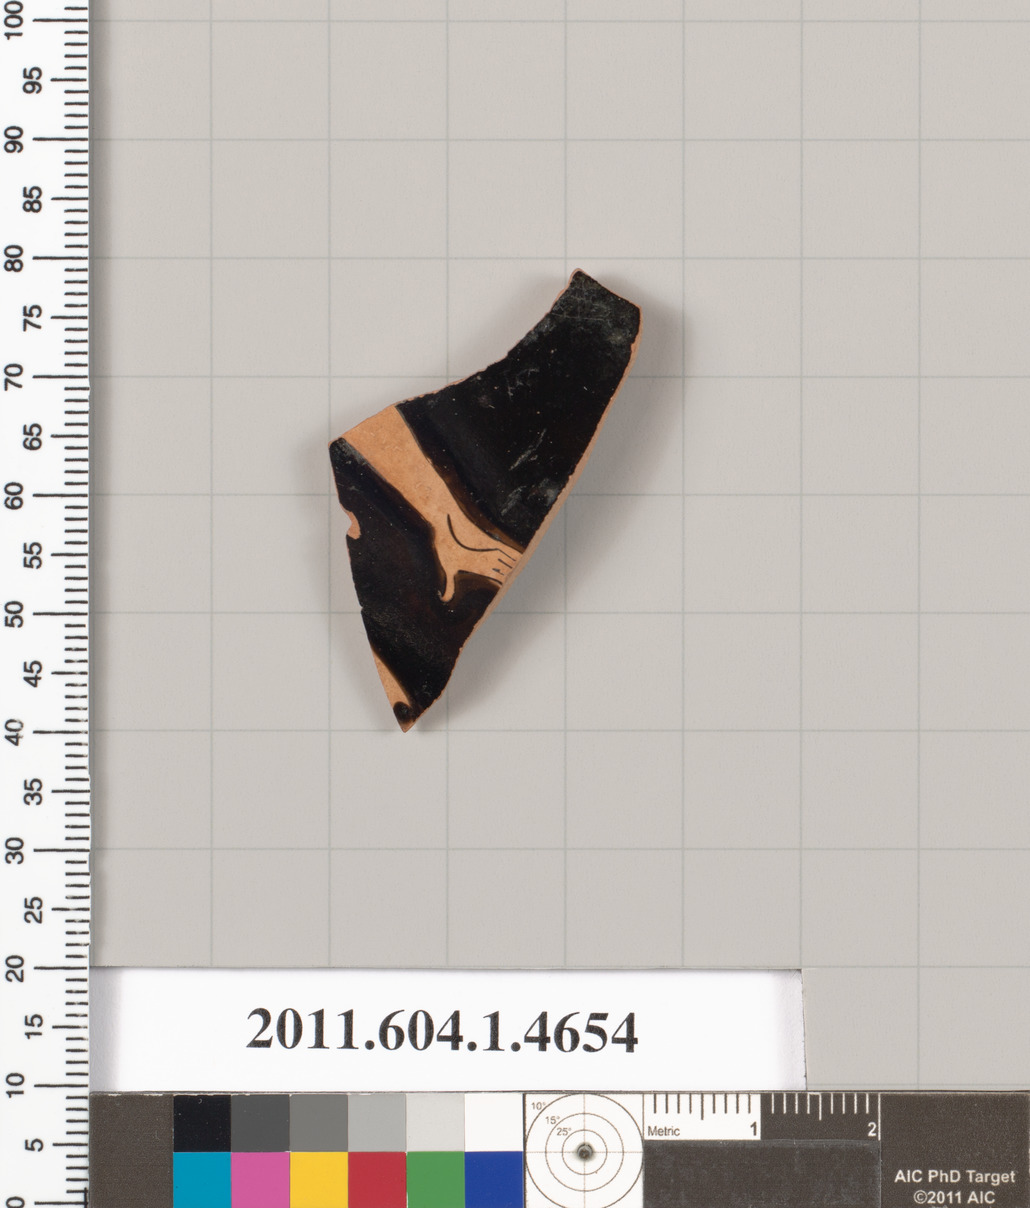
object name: kylix fragment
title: Terracotta fragment of a kylix (drinking cup)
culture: greek, attic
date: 490-470 BCE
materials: terracotta